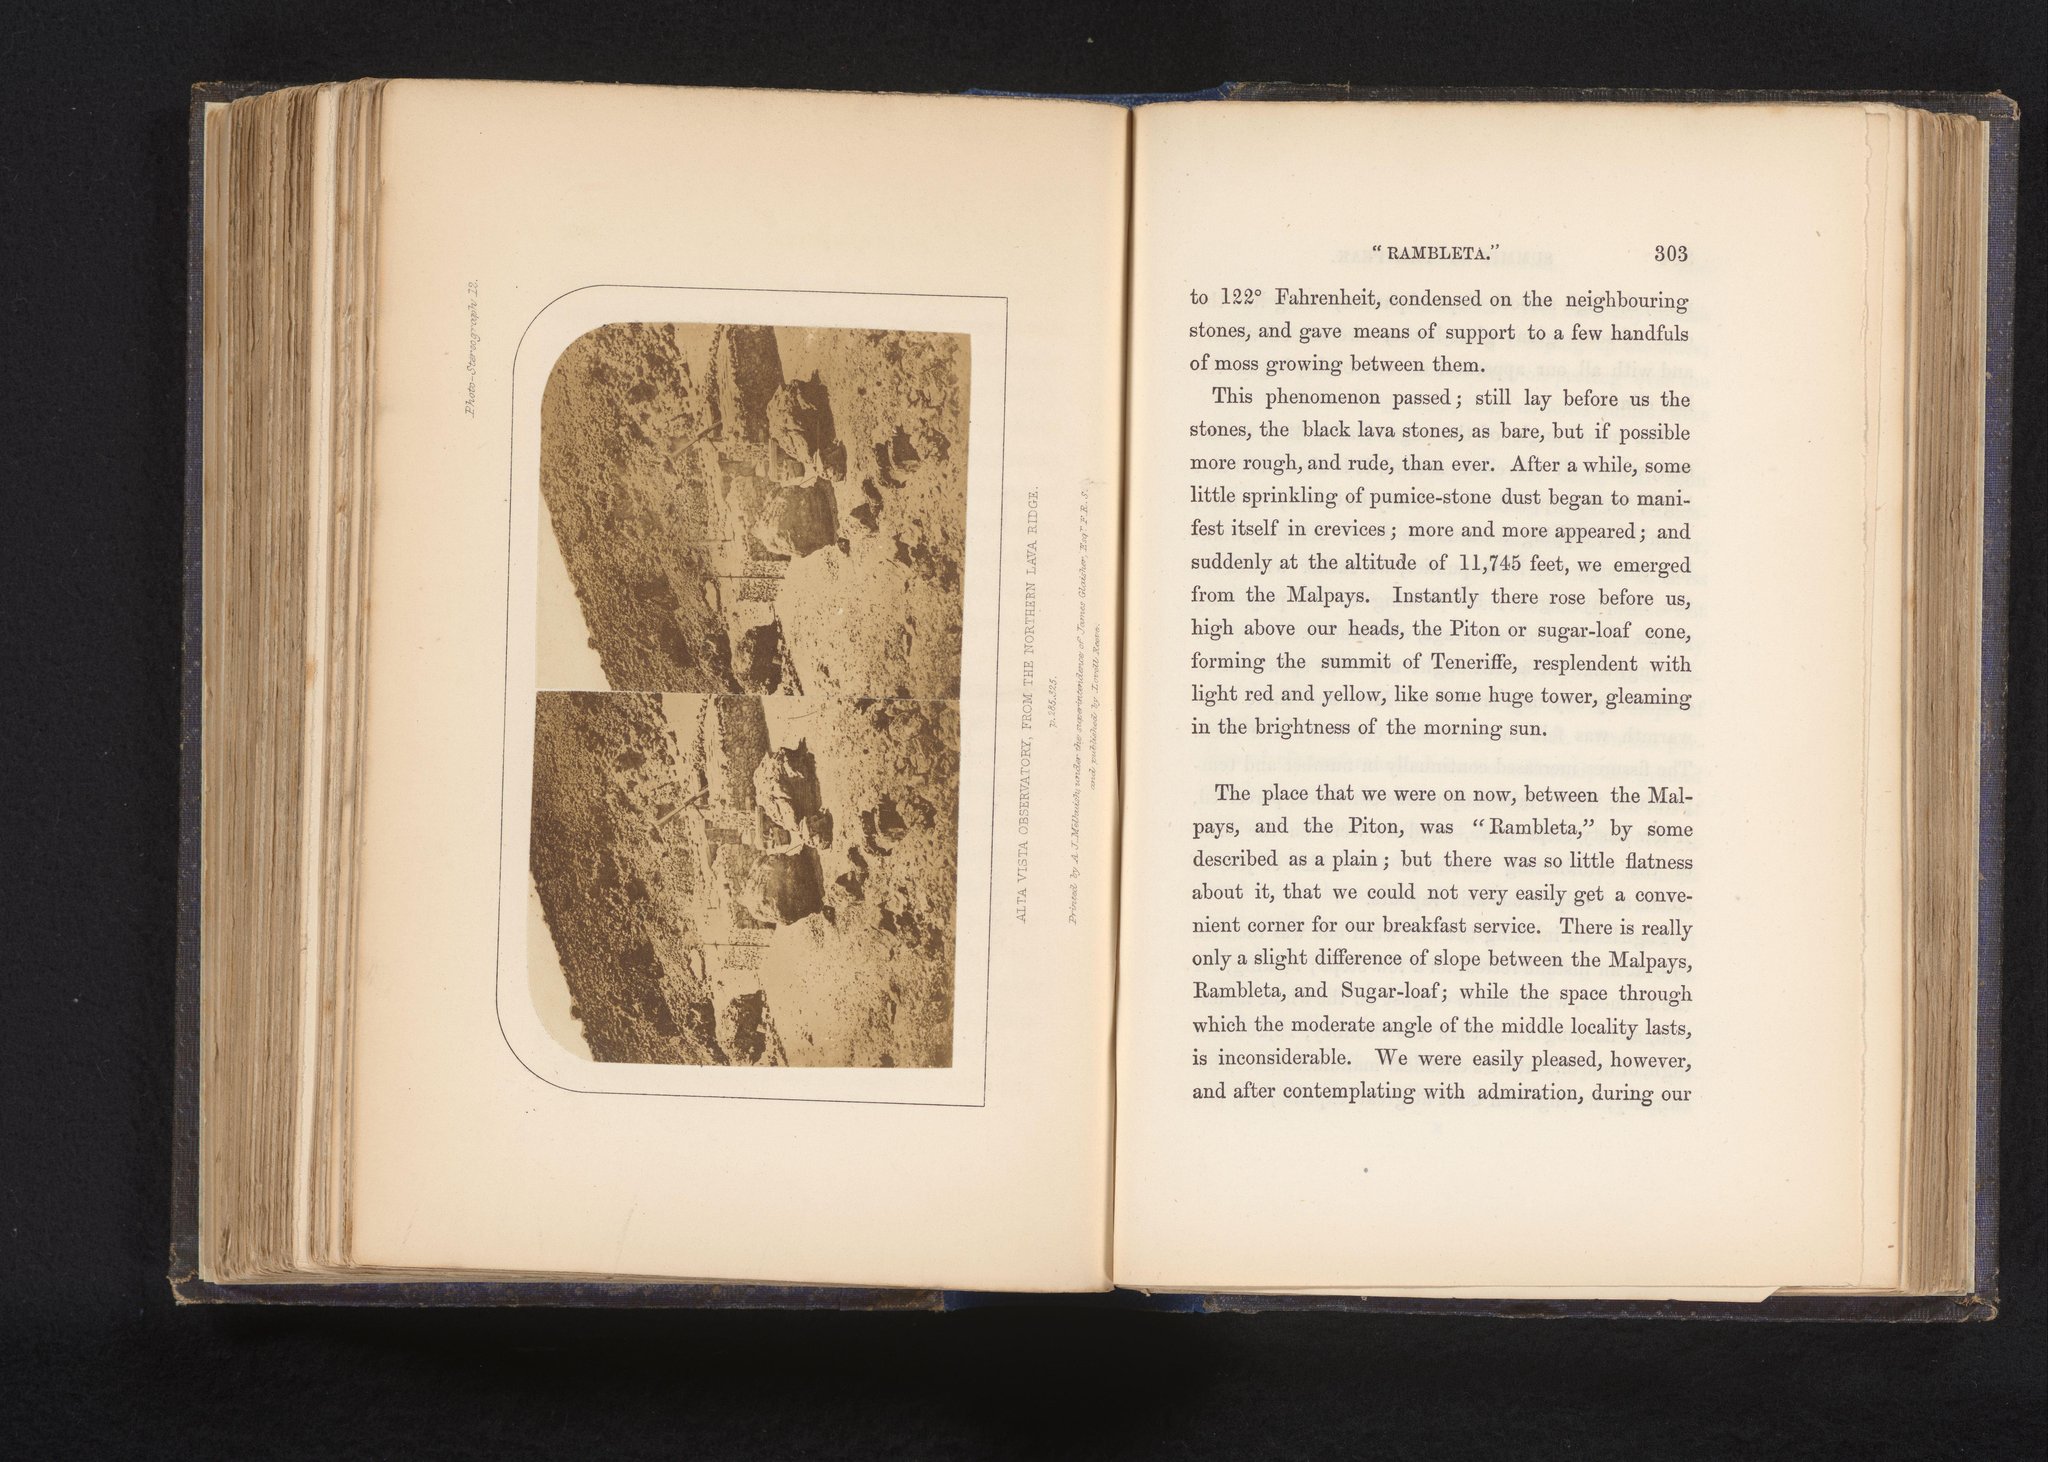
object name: page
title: Alta Vista Observatory, from the northern lava ridge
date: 1856-1858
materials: paper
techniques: albumen print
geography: tenerife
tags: telescope, rocks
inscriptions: inscription: ‘Photo-Stereograph 12.’